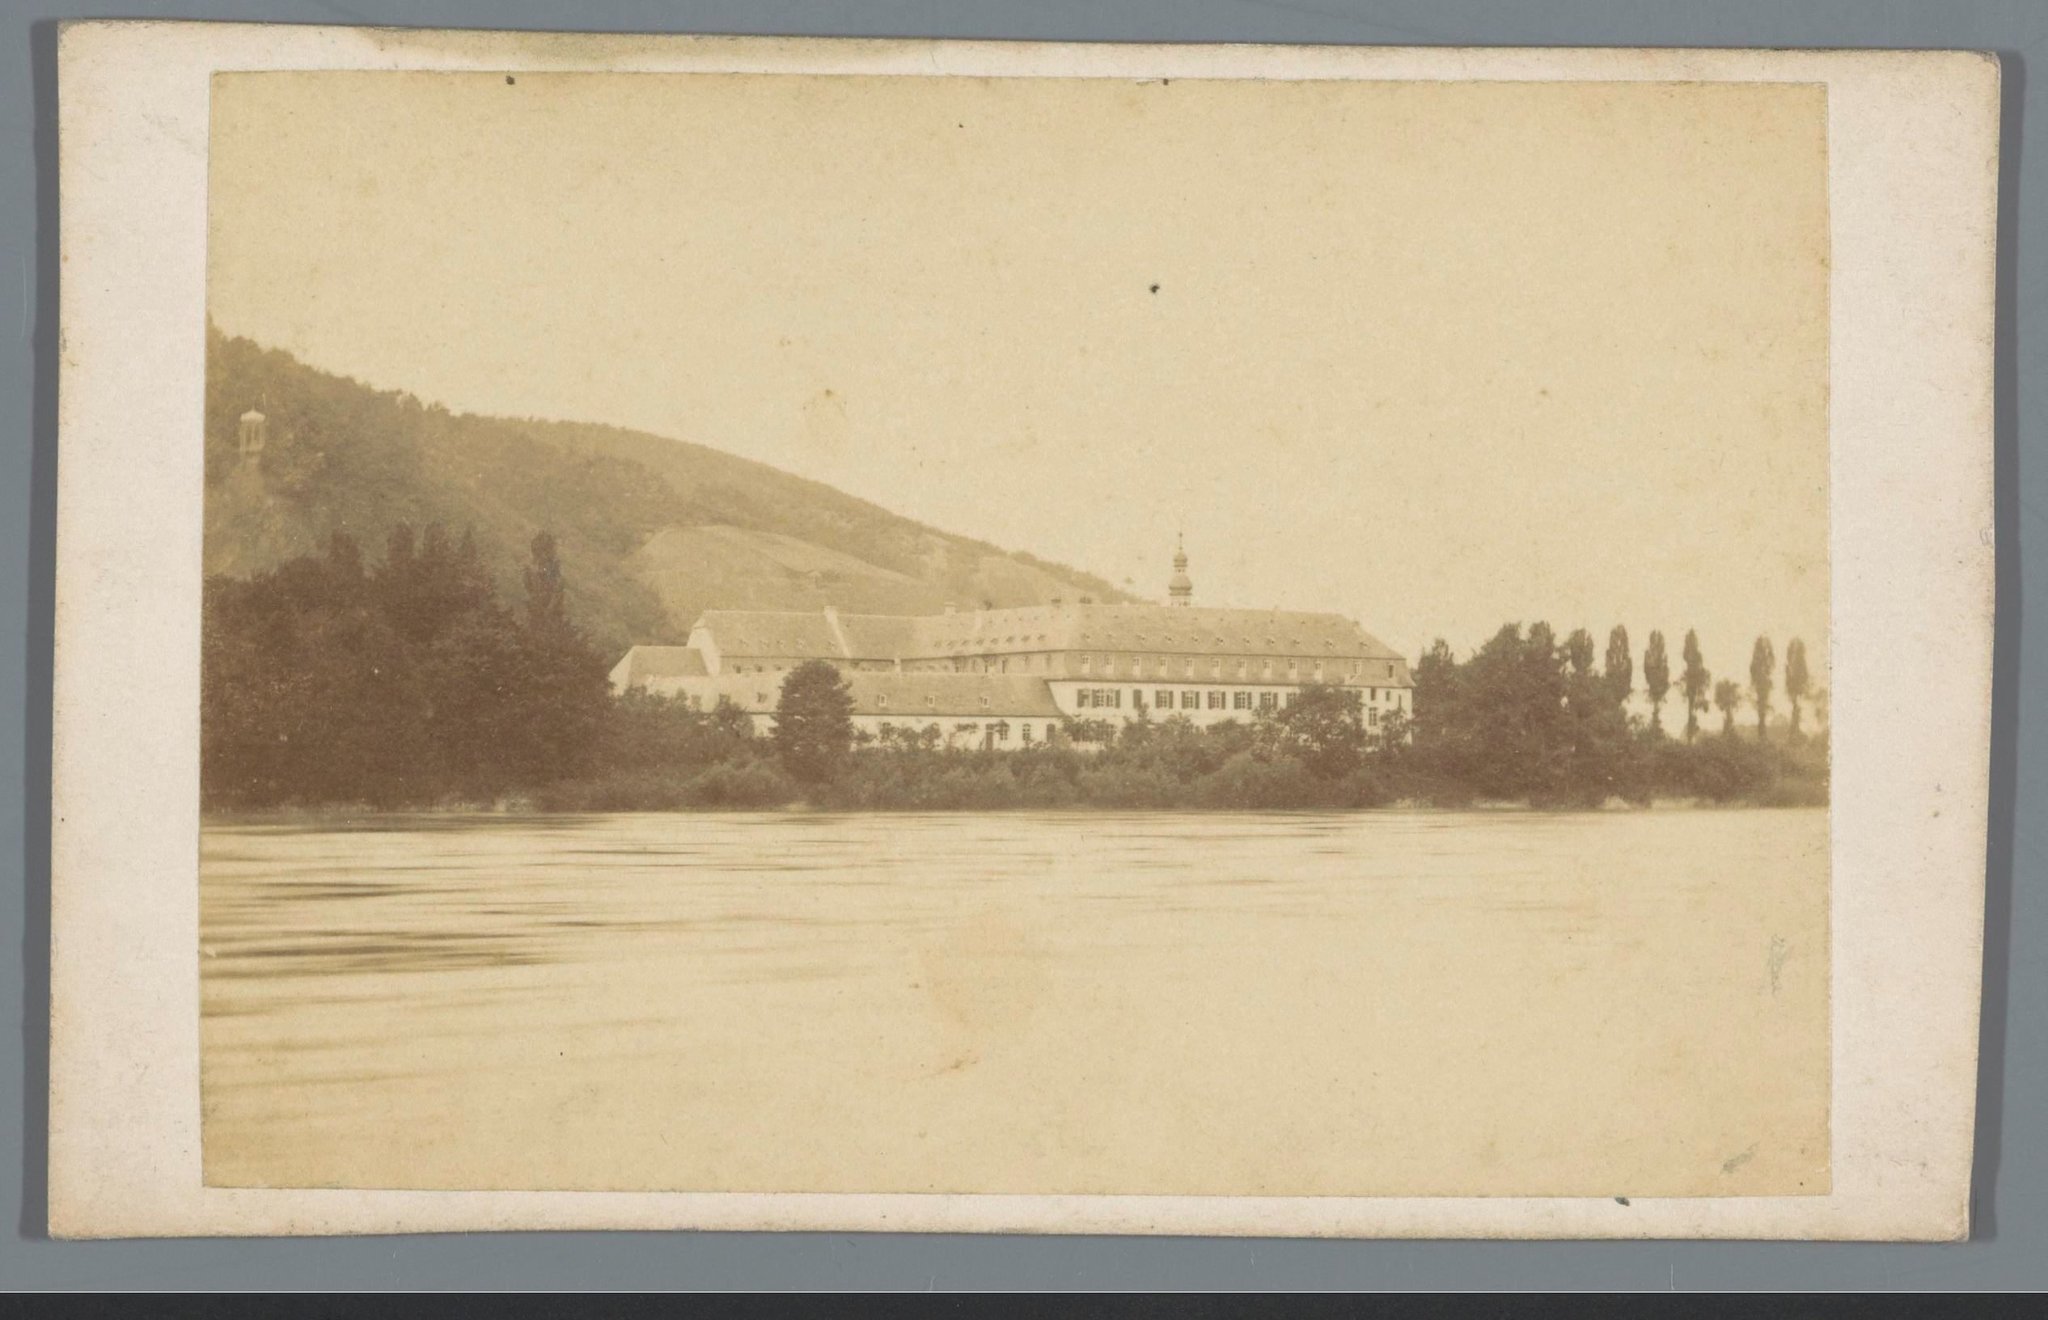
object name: carte de visite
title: Nonnenwerth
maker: Anonymous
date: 1855-1885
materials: cardboard, paper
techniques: albumen print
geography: nonnenwerth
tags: island, river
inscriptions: number: ‘Nro. 79.’